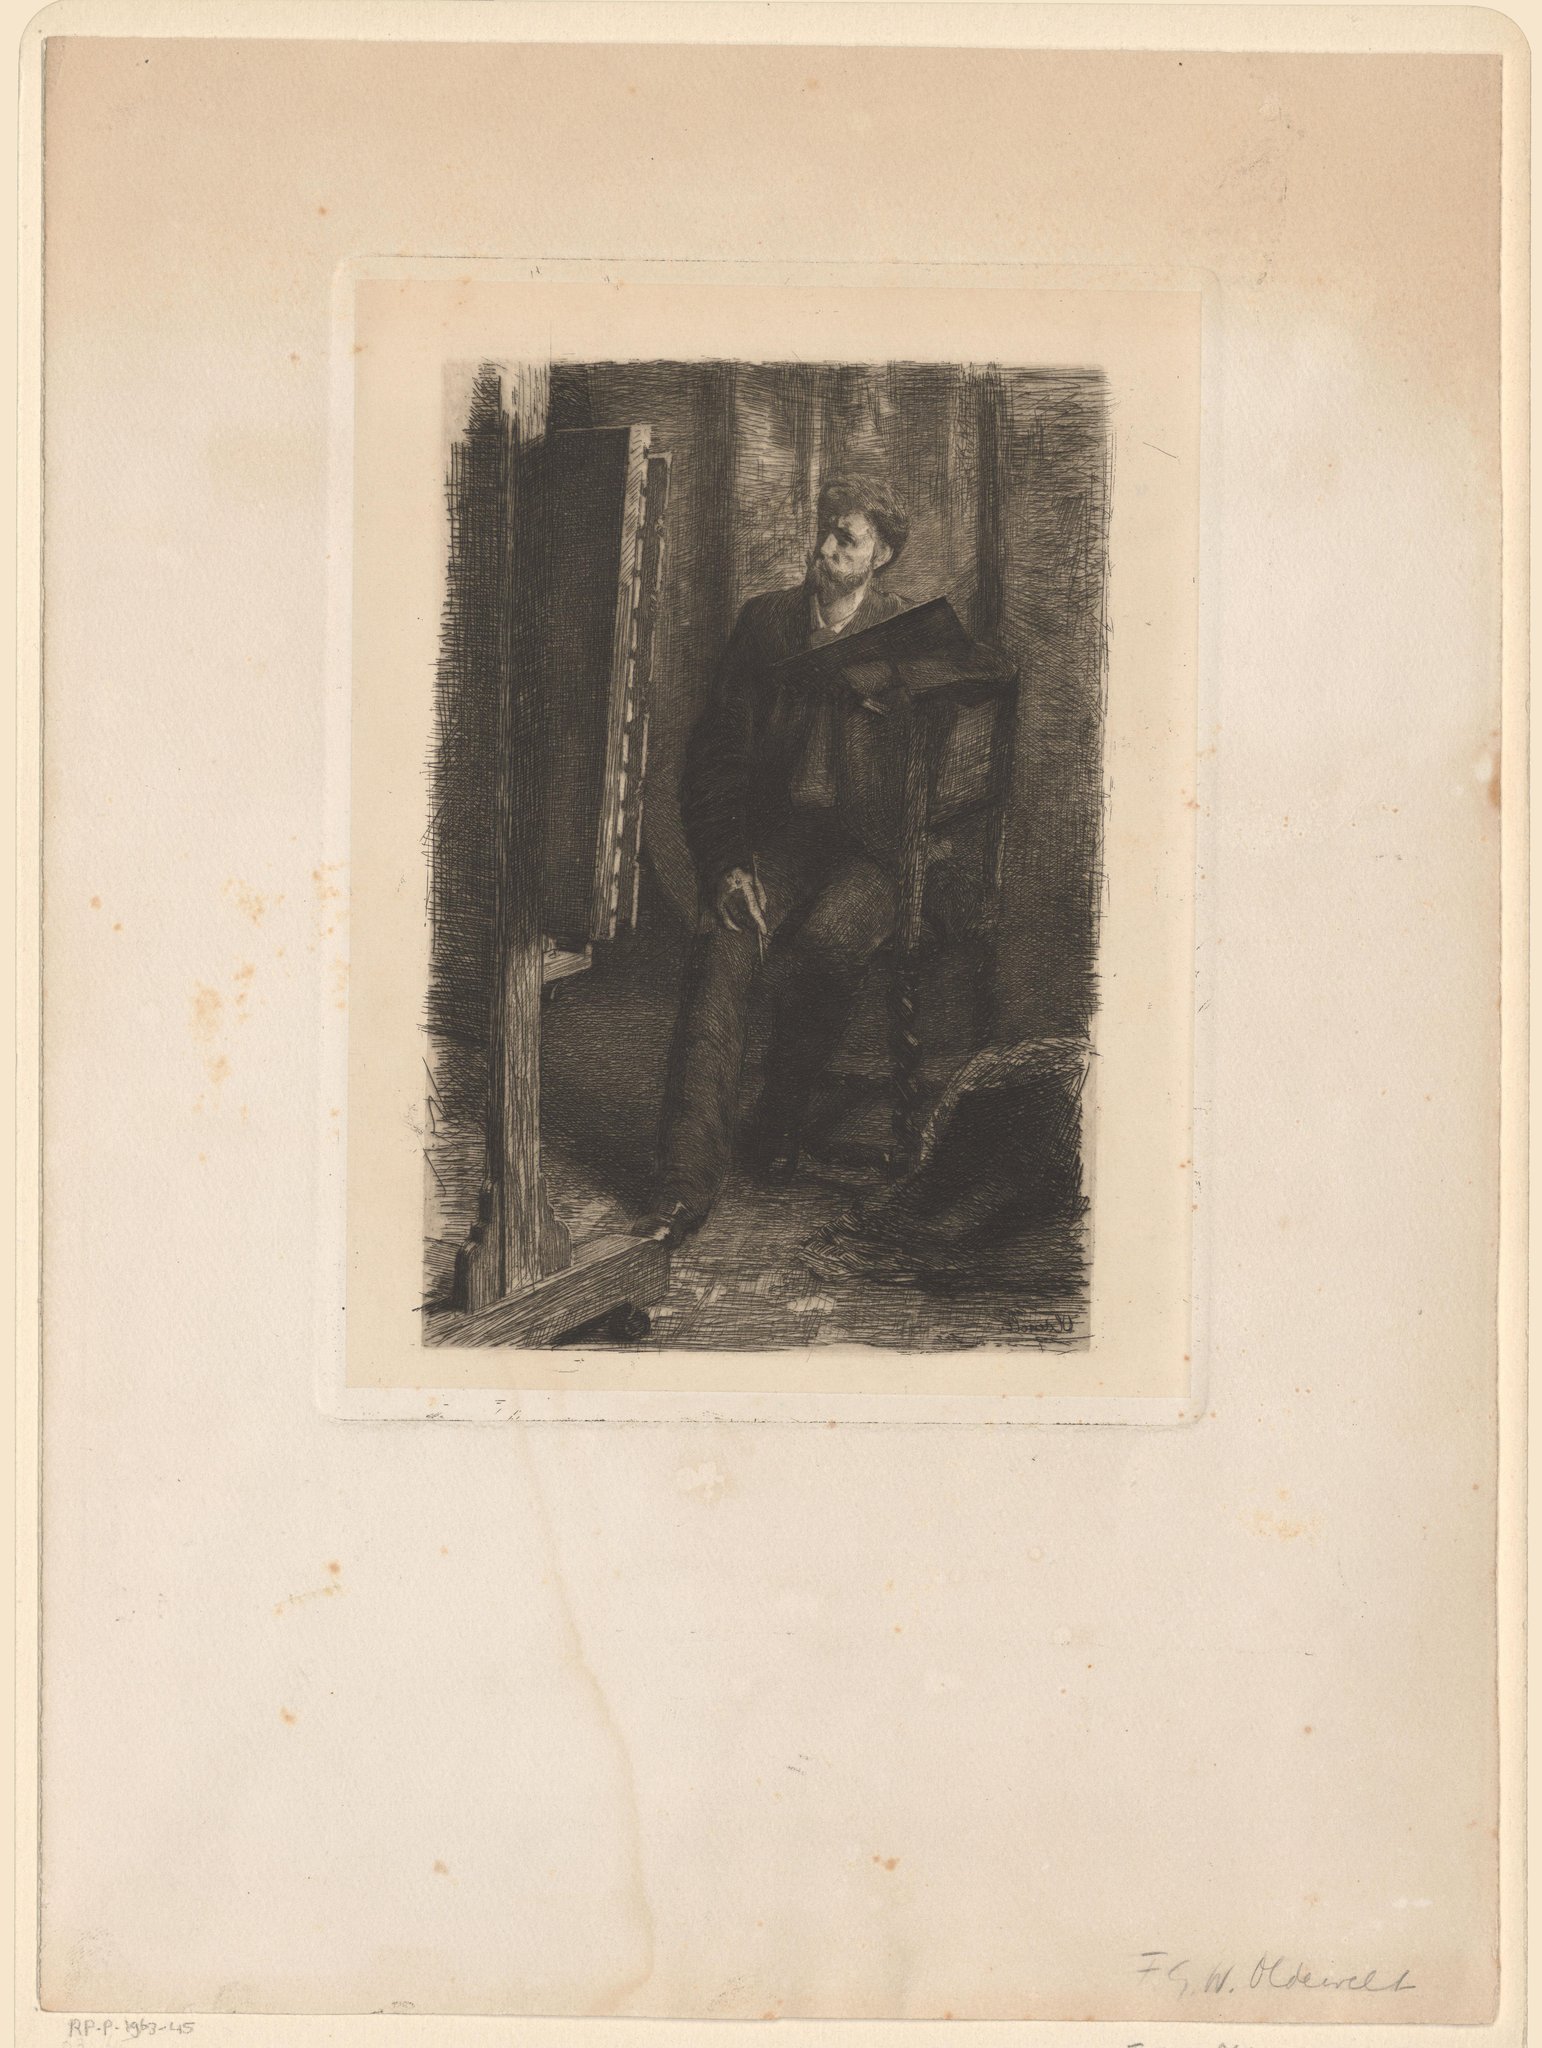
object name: print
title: Zelfportret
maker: ferdinand oldewelt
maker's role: draughtsman, print maker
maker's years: 1857-1935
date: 1888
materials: paper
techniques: drypoint, etching, intaglio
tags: amsterdam, print maker, draughtsman, ferdinand oldewelt, historical persons, painter at work, in his studio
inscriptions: collector's mark: Lugt 2228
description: Prent mogelijk uit: Vosmaer, Carel. De distel, etsen van Nederlandsche schilders. Amsterdam: Tjomme van Holkema, 1888, dl. 3.